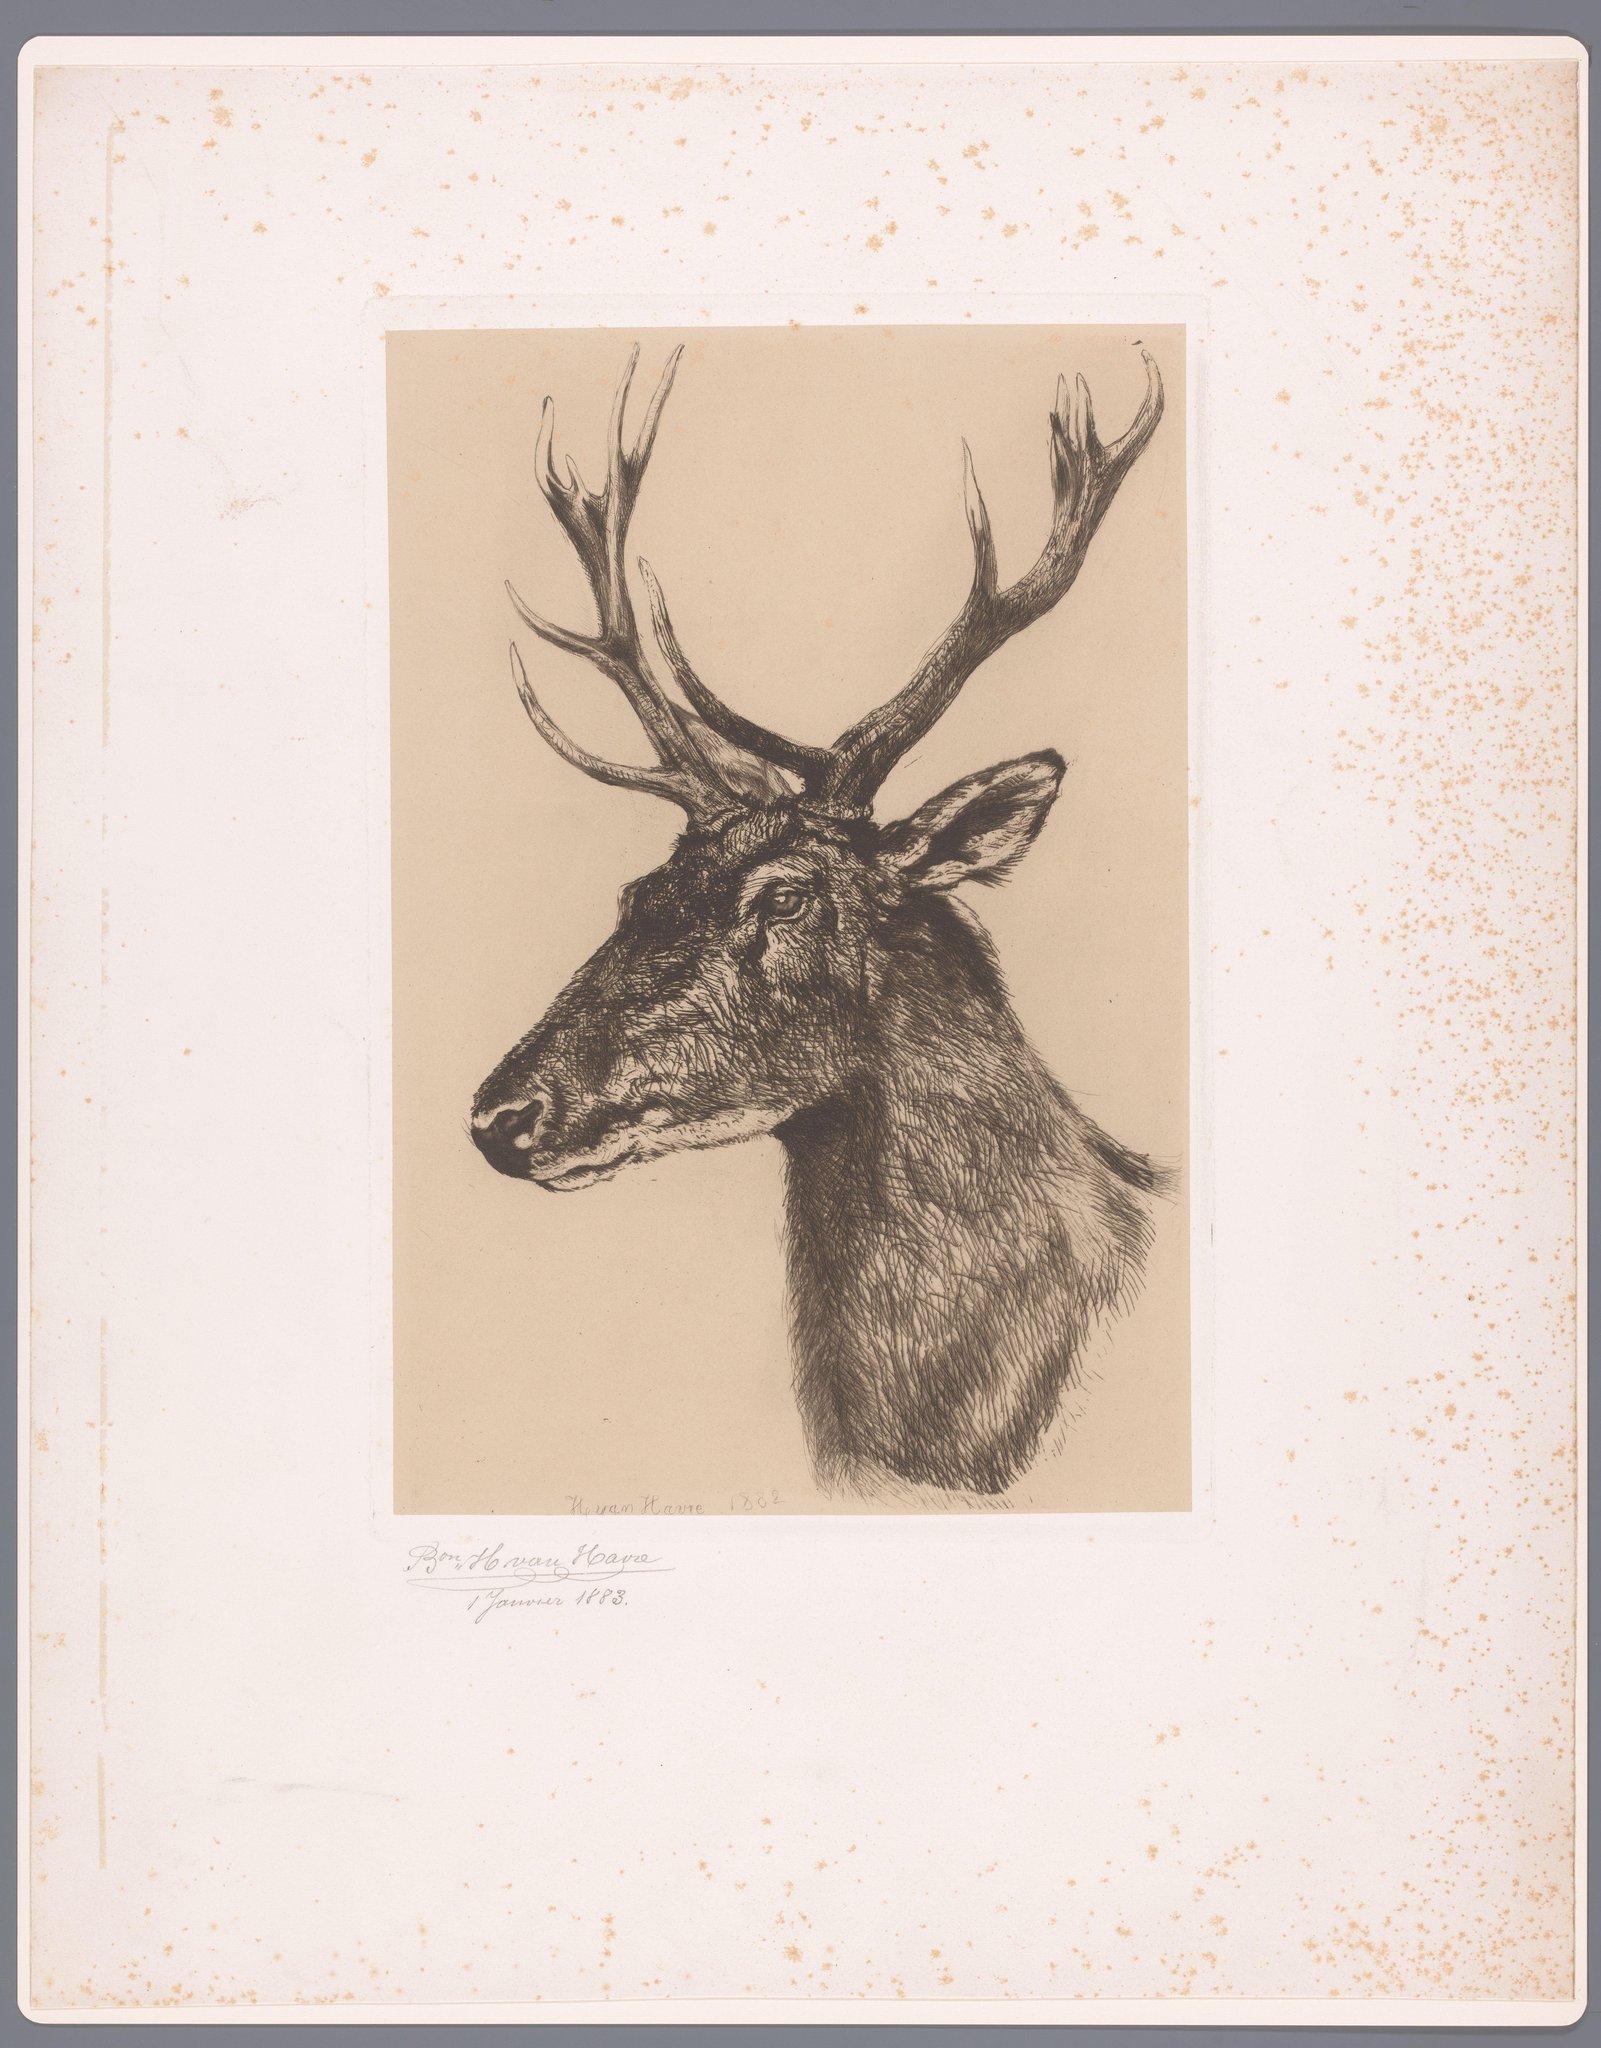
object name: print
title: Hertenkop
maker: b.h. van havre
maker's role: print maker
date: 1882-1883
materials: paper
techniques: drypoint, etching, intaglio, roulette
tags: hoofed animals: deer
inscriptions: collector's mark: Lugt 2228, inscription: ‘Bon H van Havre; 1 Janvier 1883’